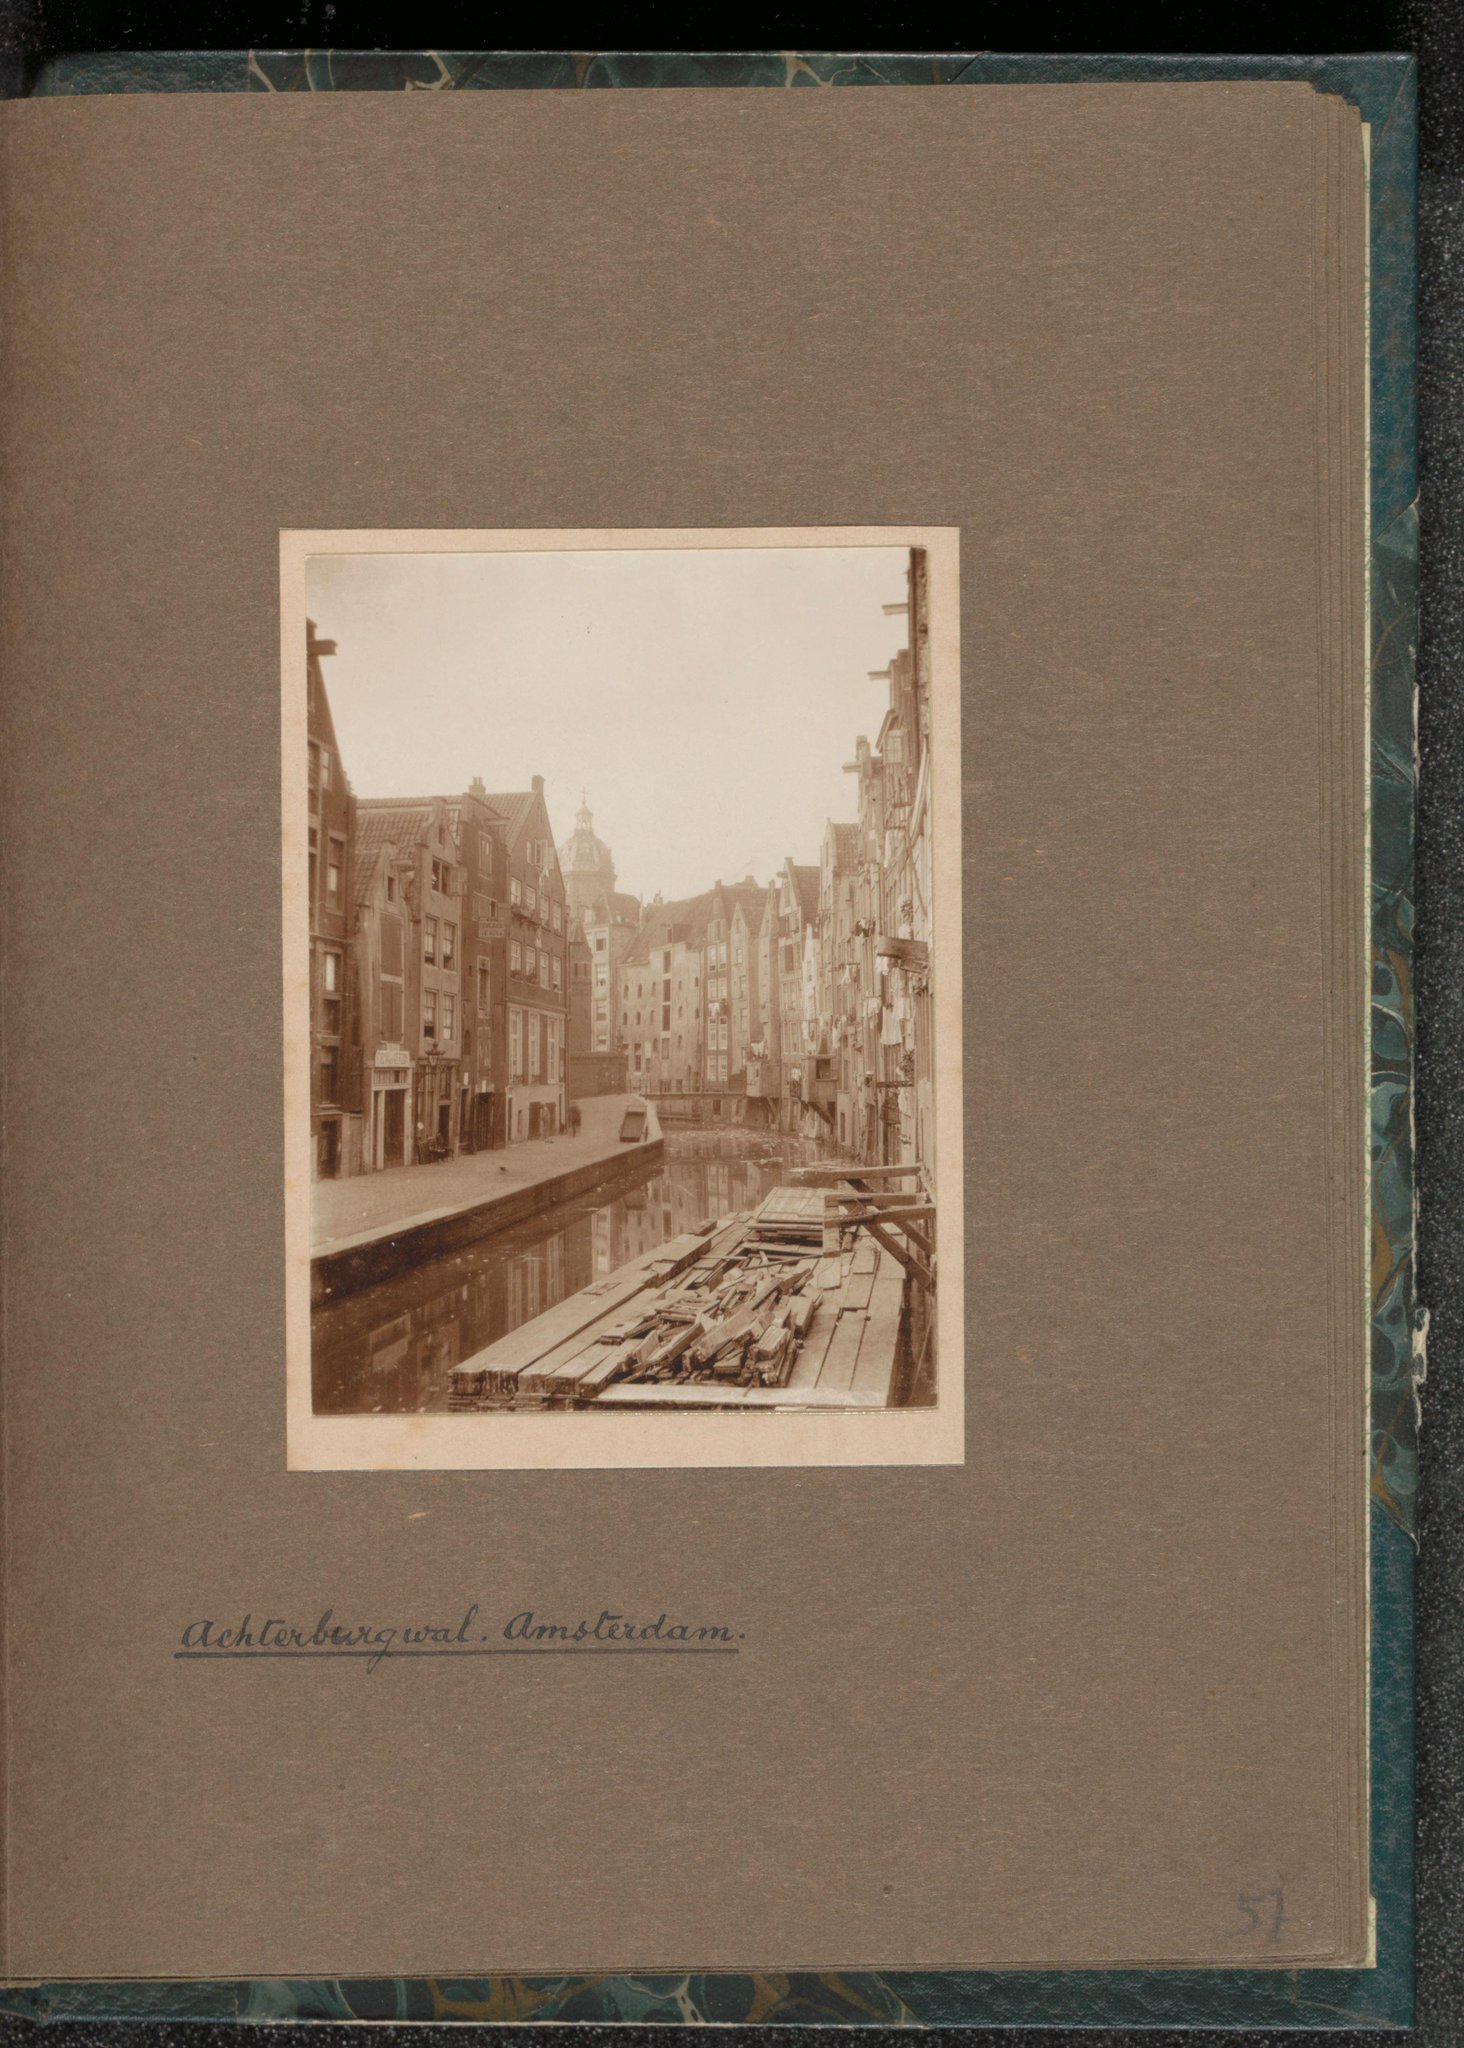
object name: photograph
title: Huizen aan de Oudezijds Achterburgwal te Amsterdam met op de achtergrond de koepel van de Sint-Nicolaaskerk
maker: Anonymous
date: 1912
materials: photographic support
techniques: gelatin silver print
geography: amsterdam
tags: hand-cart, canal, travelling; tourism, the usual house or row of houses, dome ~ architecture, hanging the wash to dry, (farm) wagon, freight wagon, cart, amsterdam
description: Onderdeel van Fotoalbum van de excursie naar Nederland van de Britse amateurfotografenvereniging P.C.U.K.